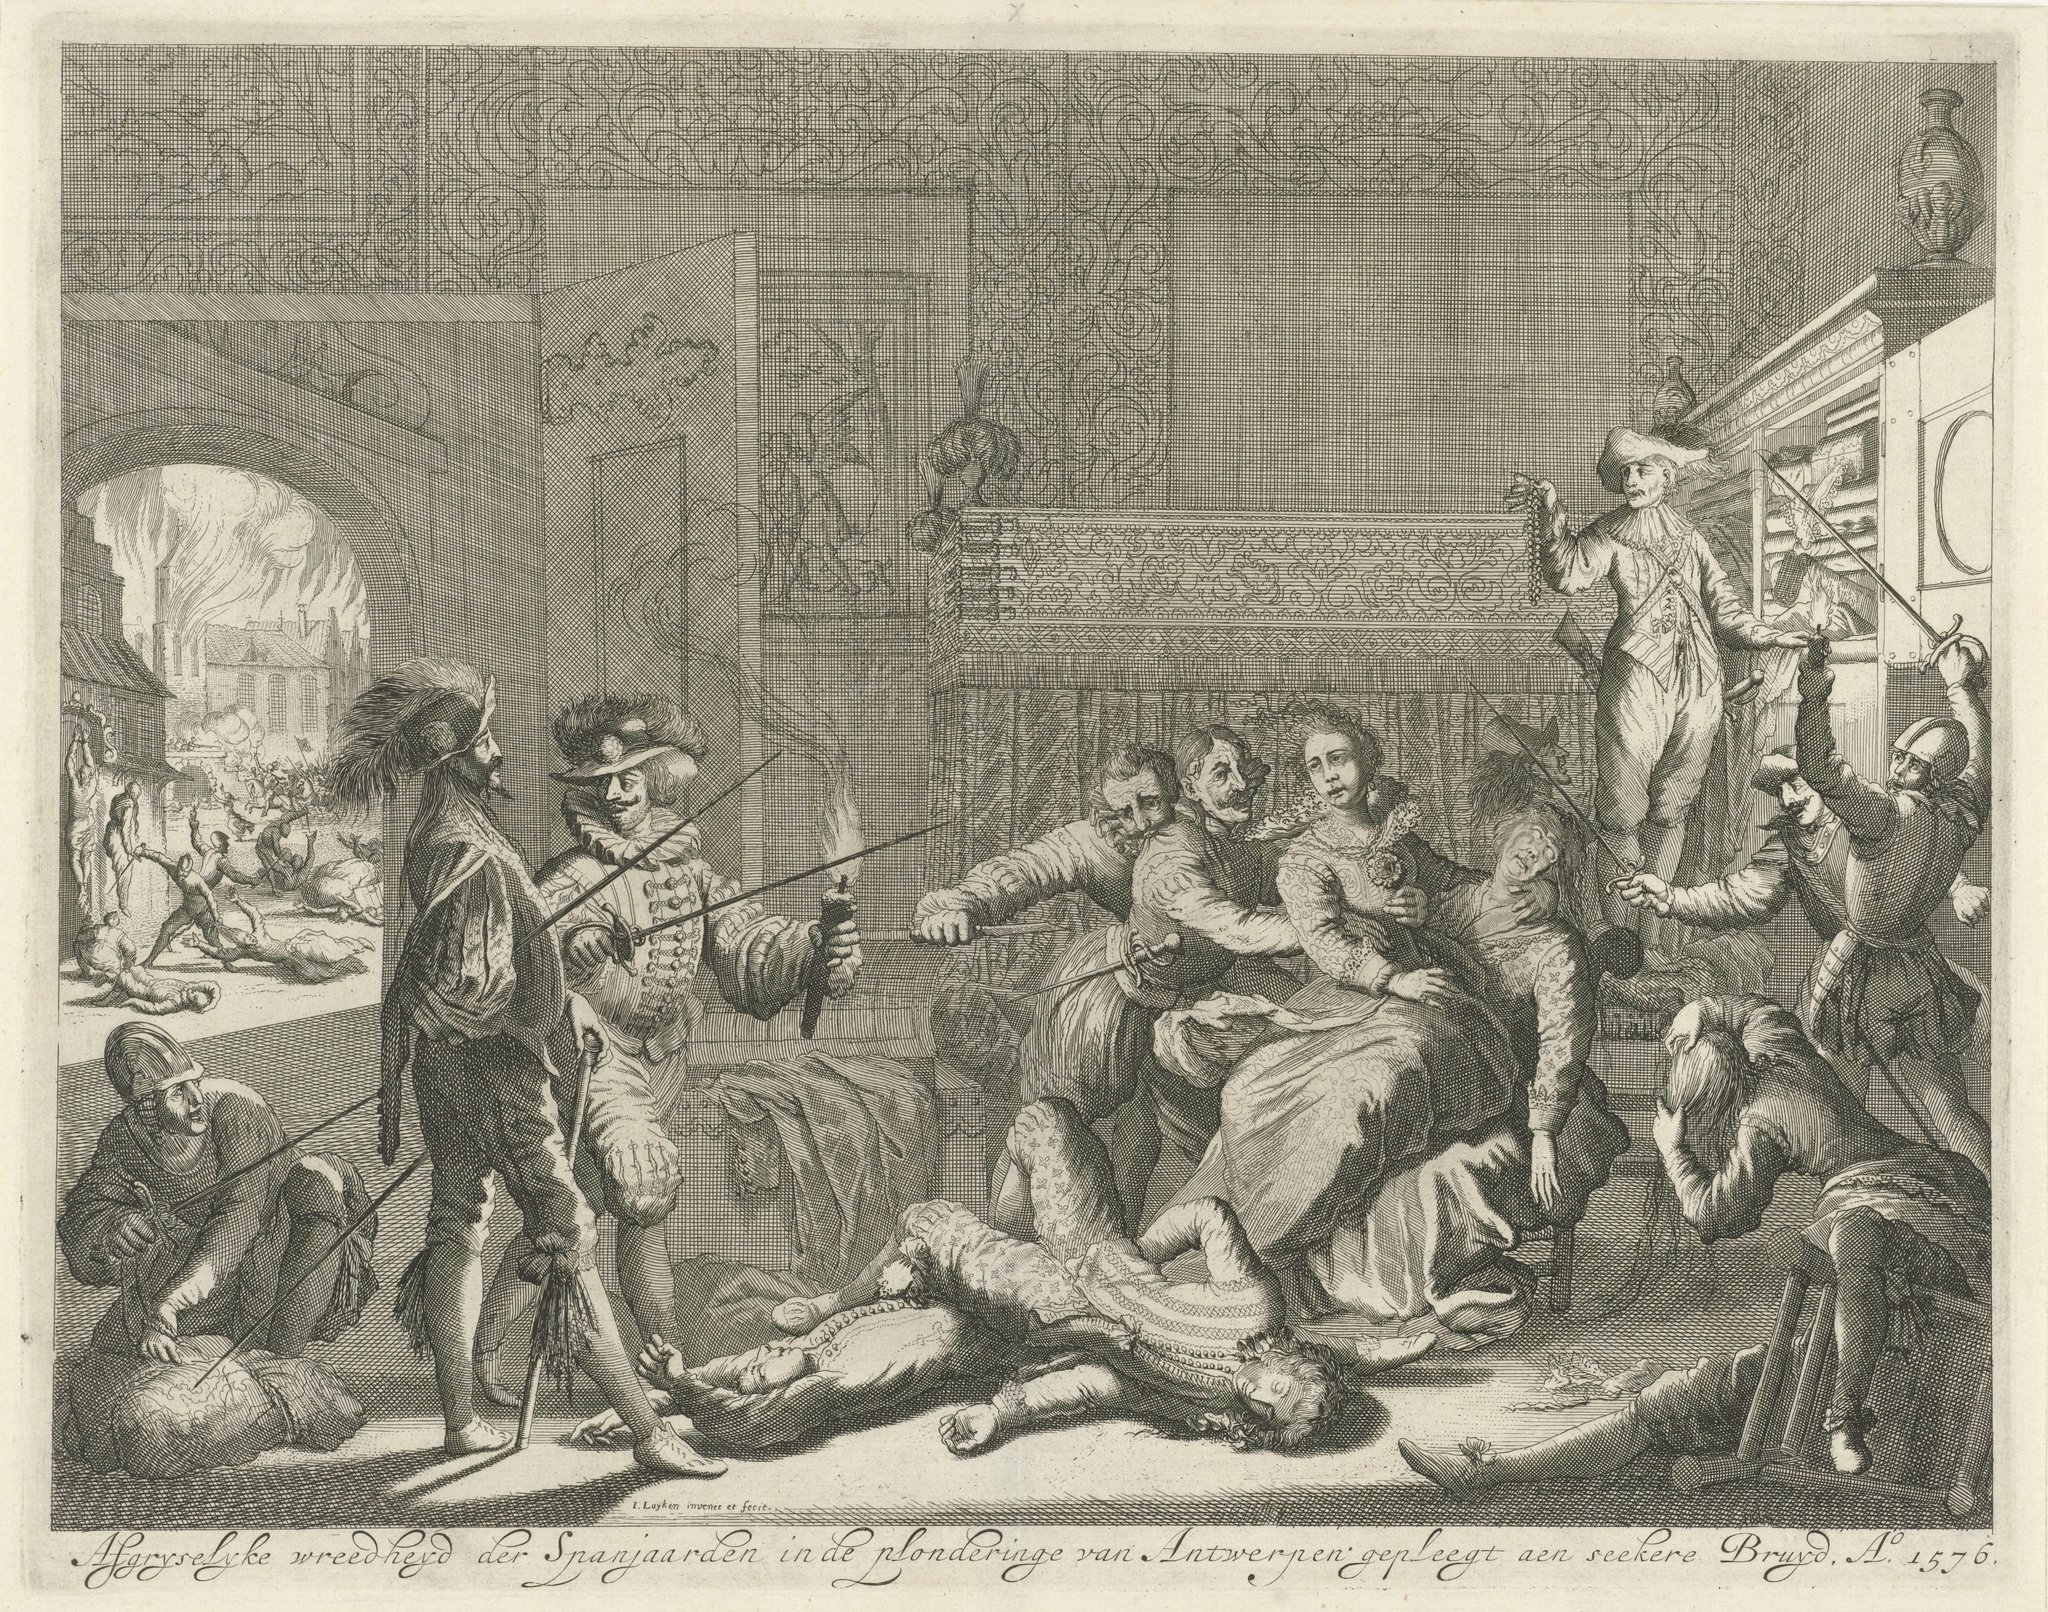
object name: print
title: Mishandeling van een bruid door Spaanse soldaten tijdens de Spaanse Furie te Antwerpen, 1576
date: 1679-1684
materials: paper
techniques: engraving, etching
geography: amsterdam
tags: plundering ~ soldiers, massacre ~ war, antwerp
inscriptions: collector's mark: Lugt 2228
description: Interieur met de mishandeling van een bruid door Spaanse soldaten tijdens de Spaanse Furie te Antwerpen, 4 november 1576. De familie van de bruid wordt vermoord en het huis geplunderd. Links door de deur is het moorden op straat te zien.